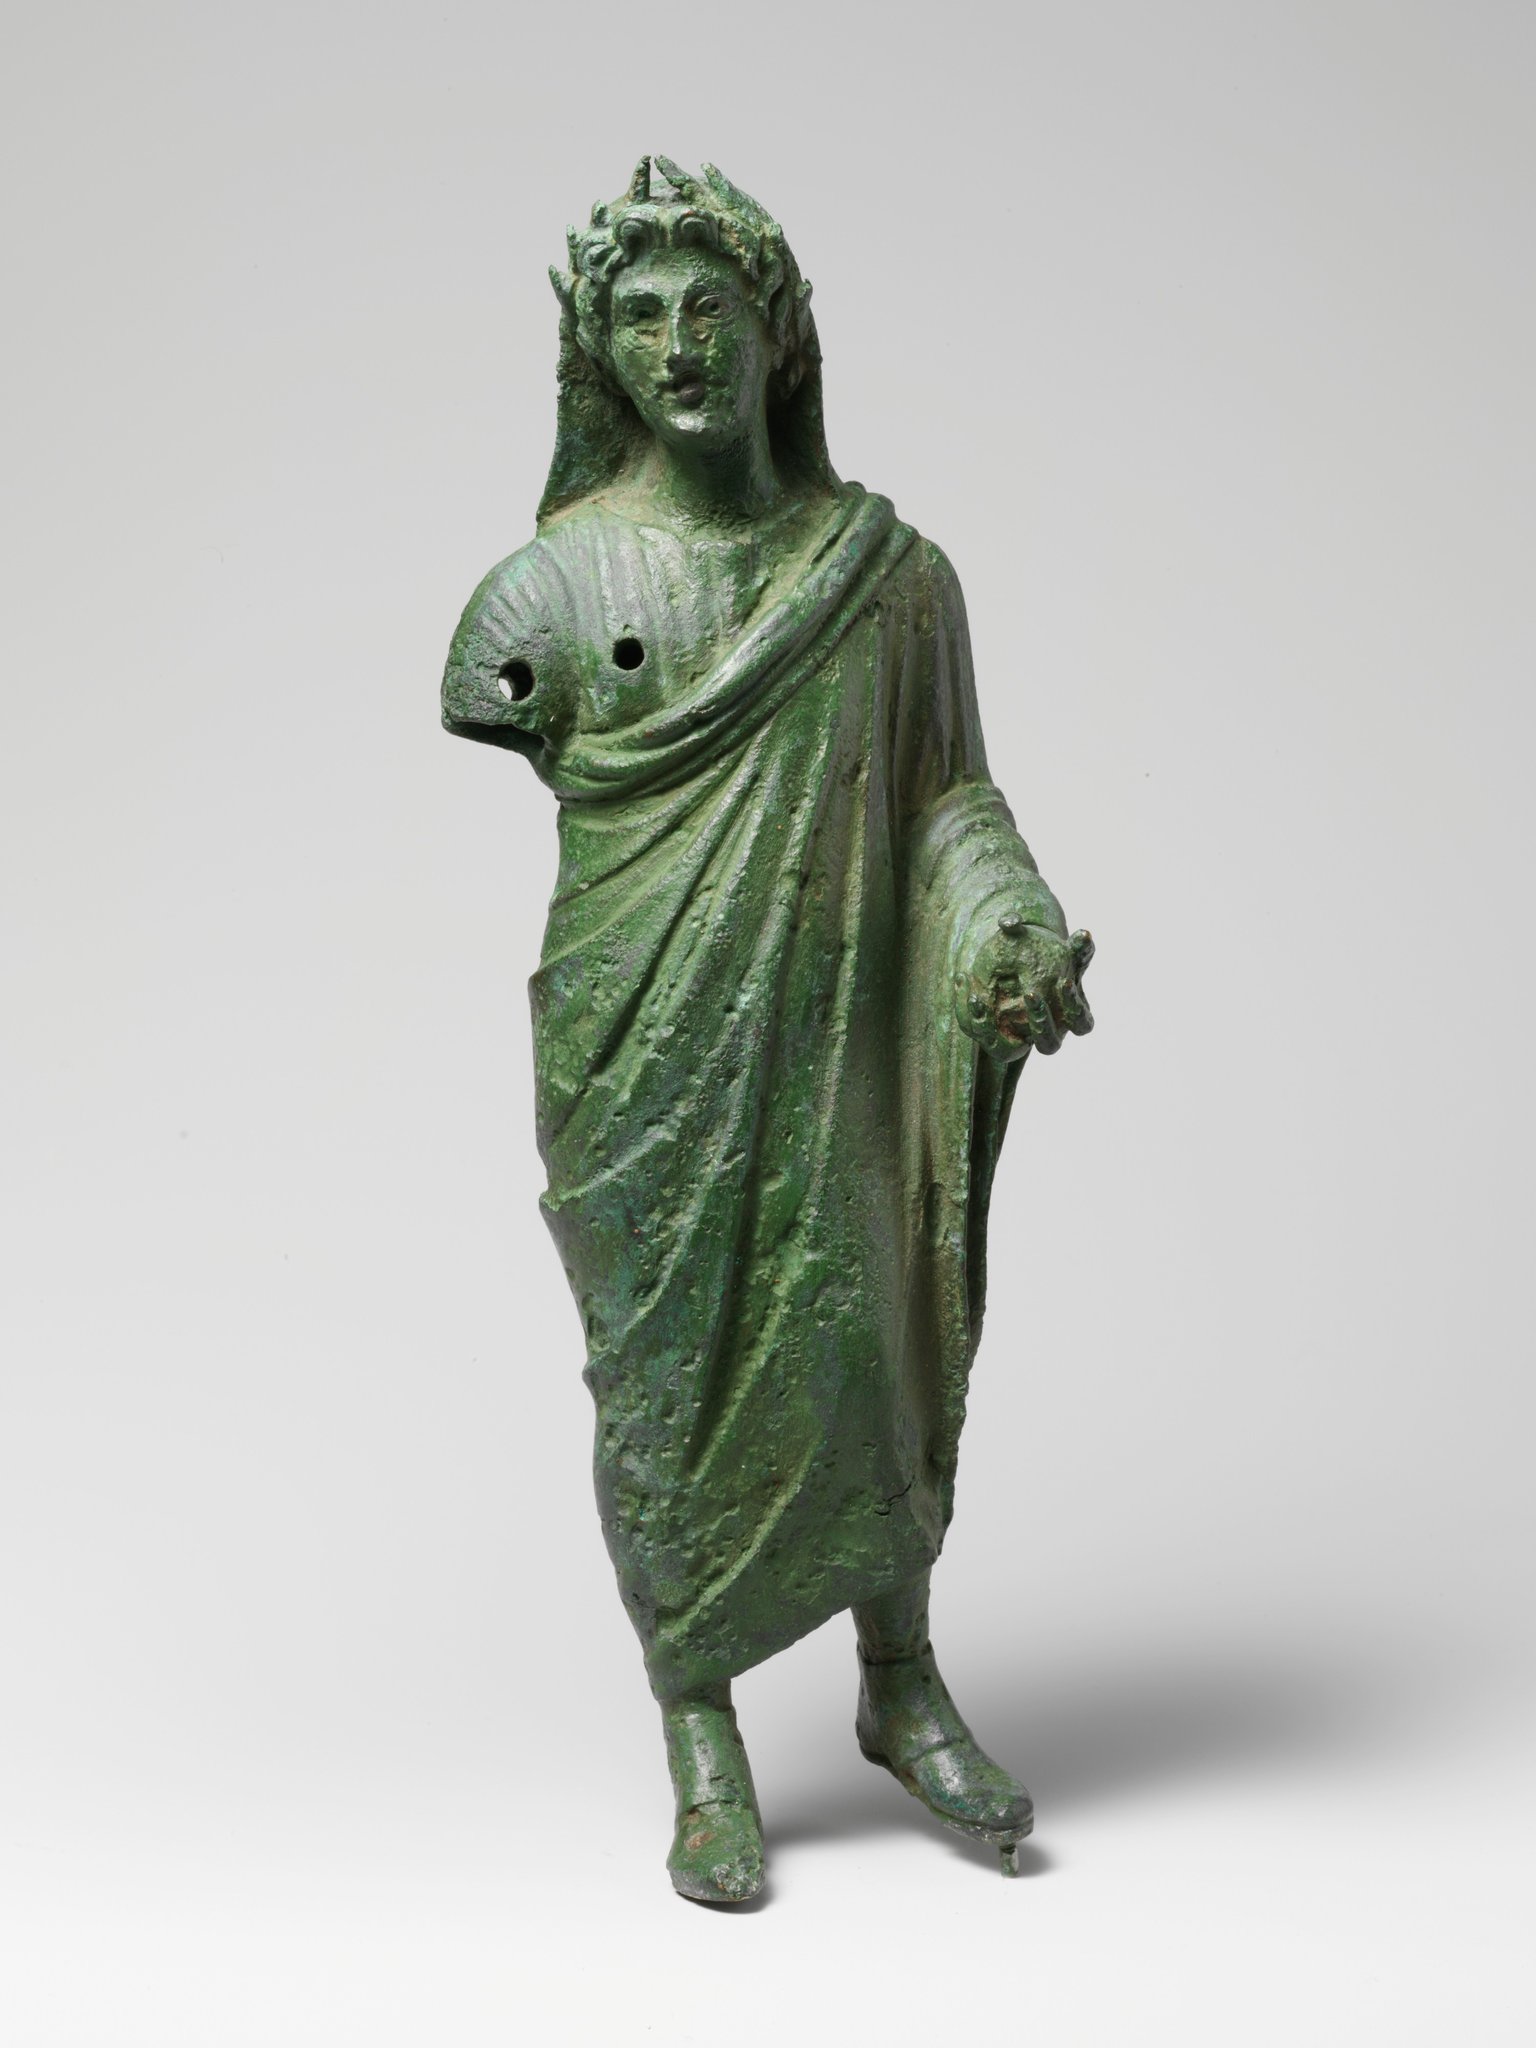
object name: statuette of a priest sacrificing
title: Bronze statuette of a priest sacrificing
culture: roman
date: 34-1 BCE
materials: bronze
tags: men